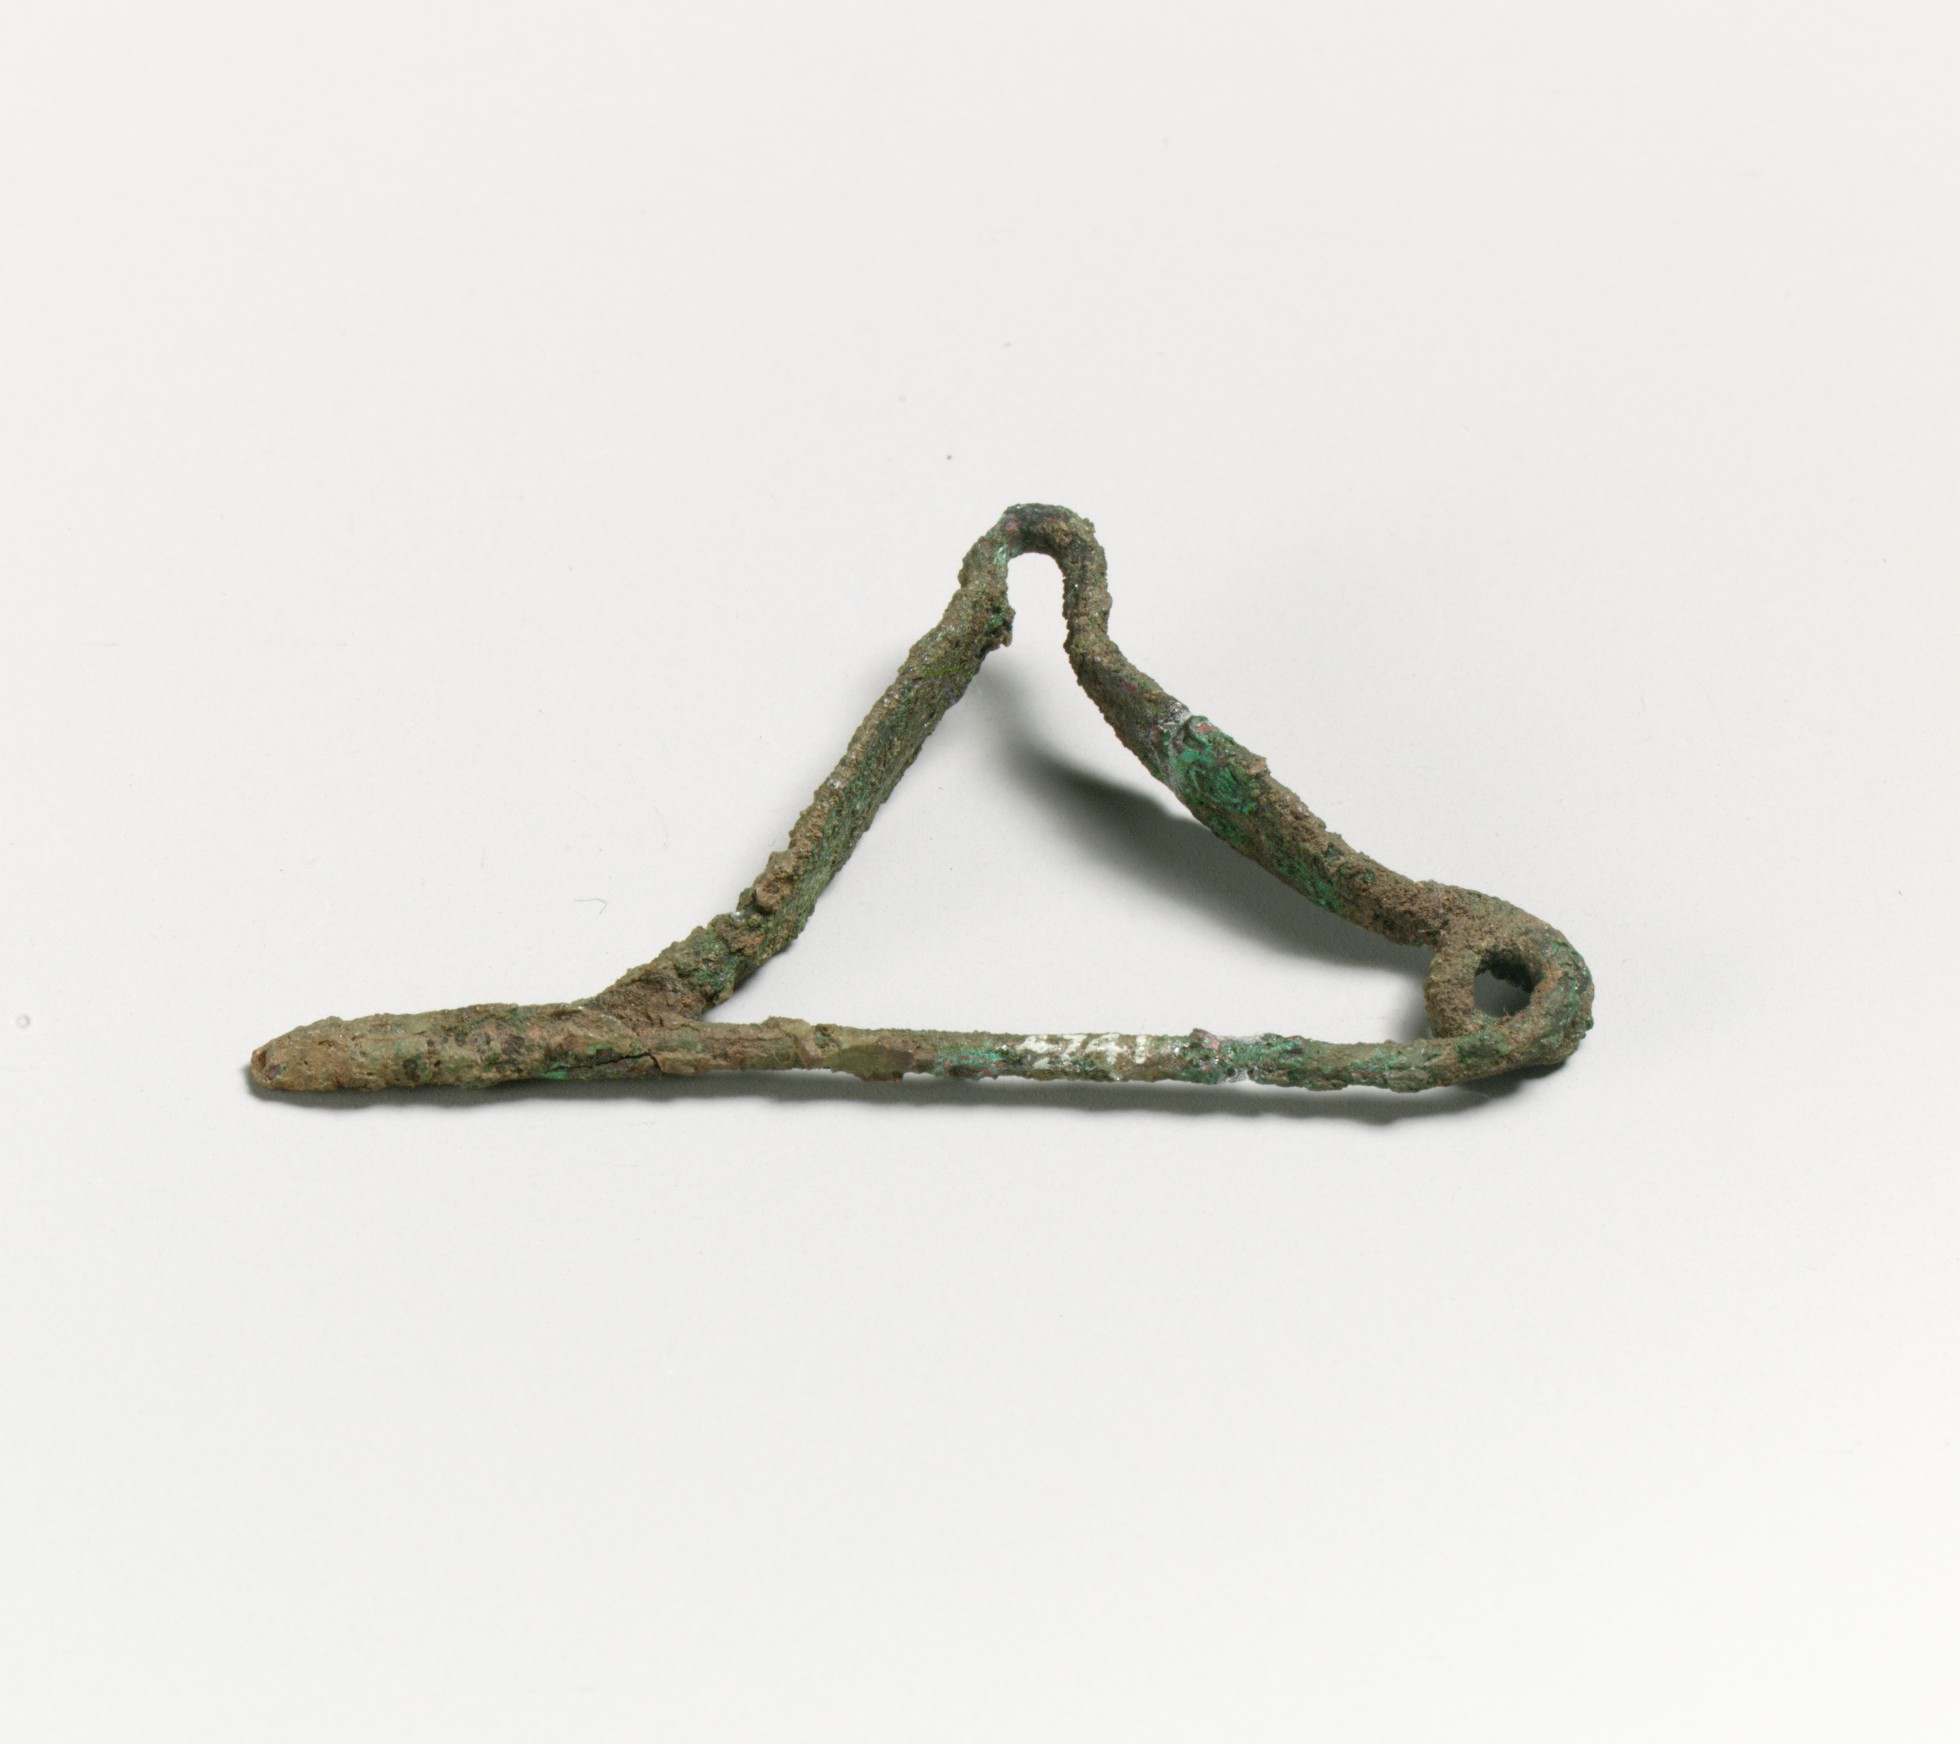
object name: fibula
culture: cypriot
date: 3900 BCE-100 CE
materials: bronze